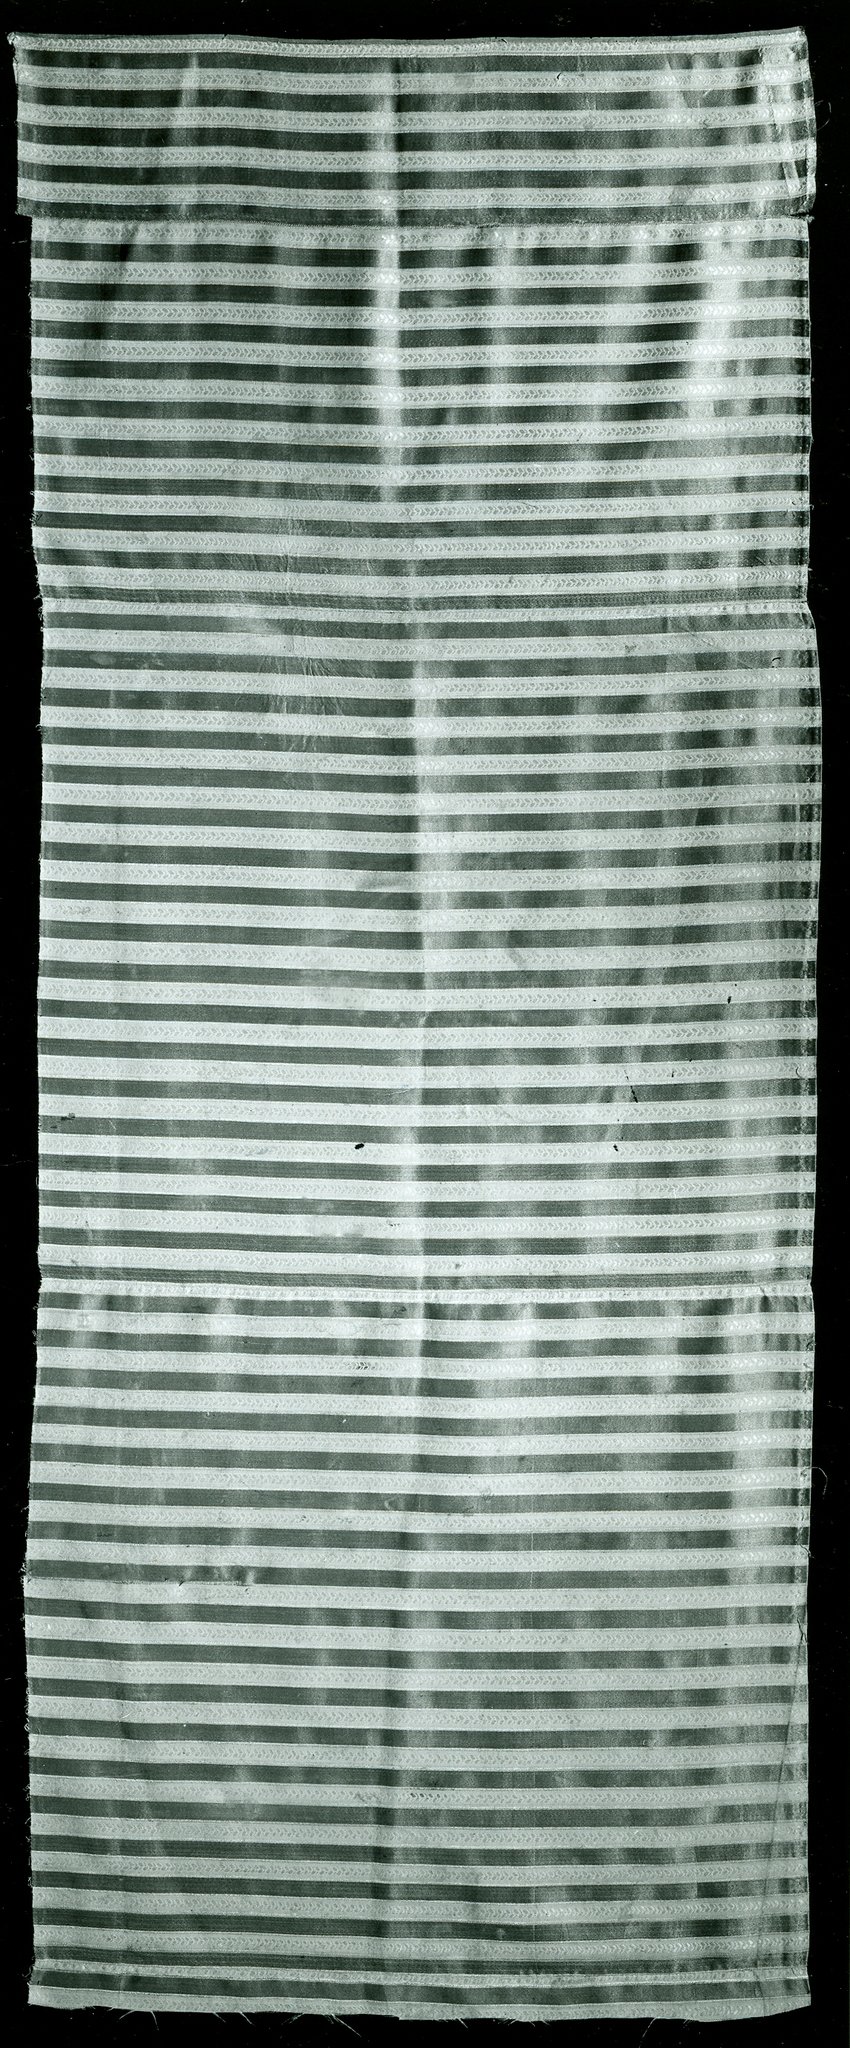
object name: textile panel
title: Panel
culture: spanish or valencian or talavera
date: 1767-1800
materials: silk